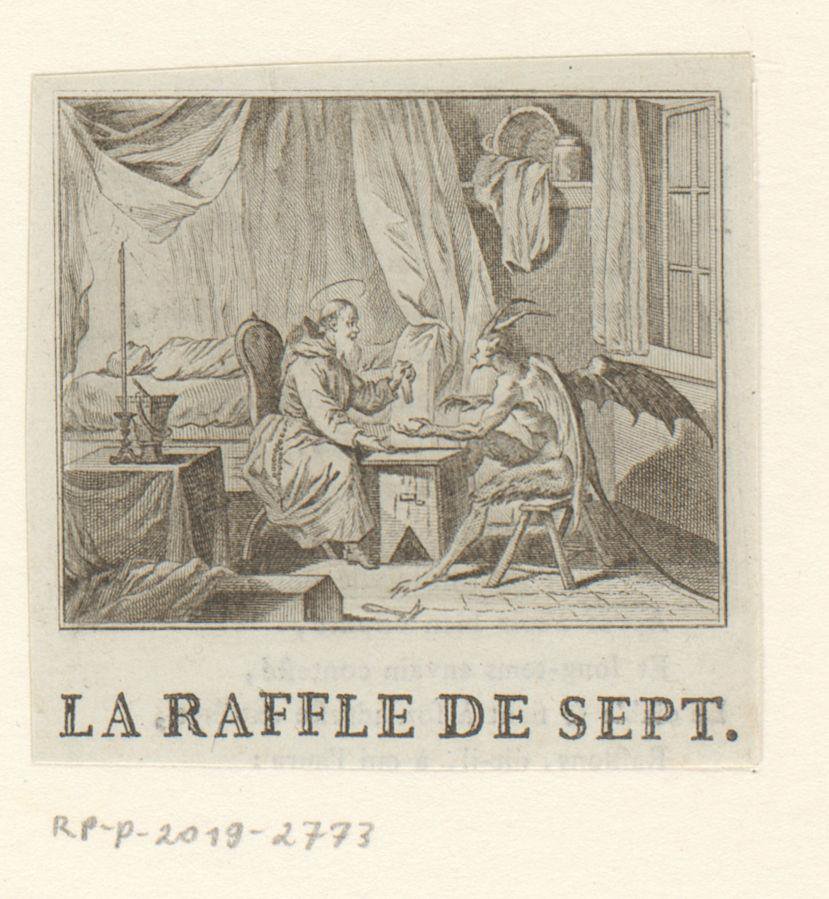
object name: book illustration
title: La raffle de sept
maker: Anonymous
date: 1763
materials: paper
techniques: engraving, etching, letterpress printing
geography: france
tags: devil(s) and demons, interior of the house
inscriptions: collector's mark: Lugt 2228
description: Mogelijk prent uit: Grecourt, Jean Baptiste Joseph Willart de. Oeuvres diverses de M. de Grécourt, nouvelle édition, augmentée d'un grand nombre de pièces, revus sur les originales et du Philotanis. Amsterdam: s.n., 1763.